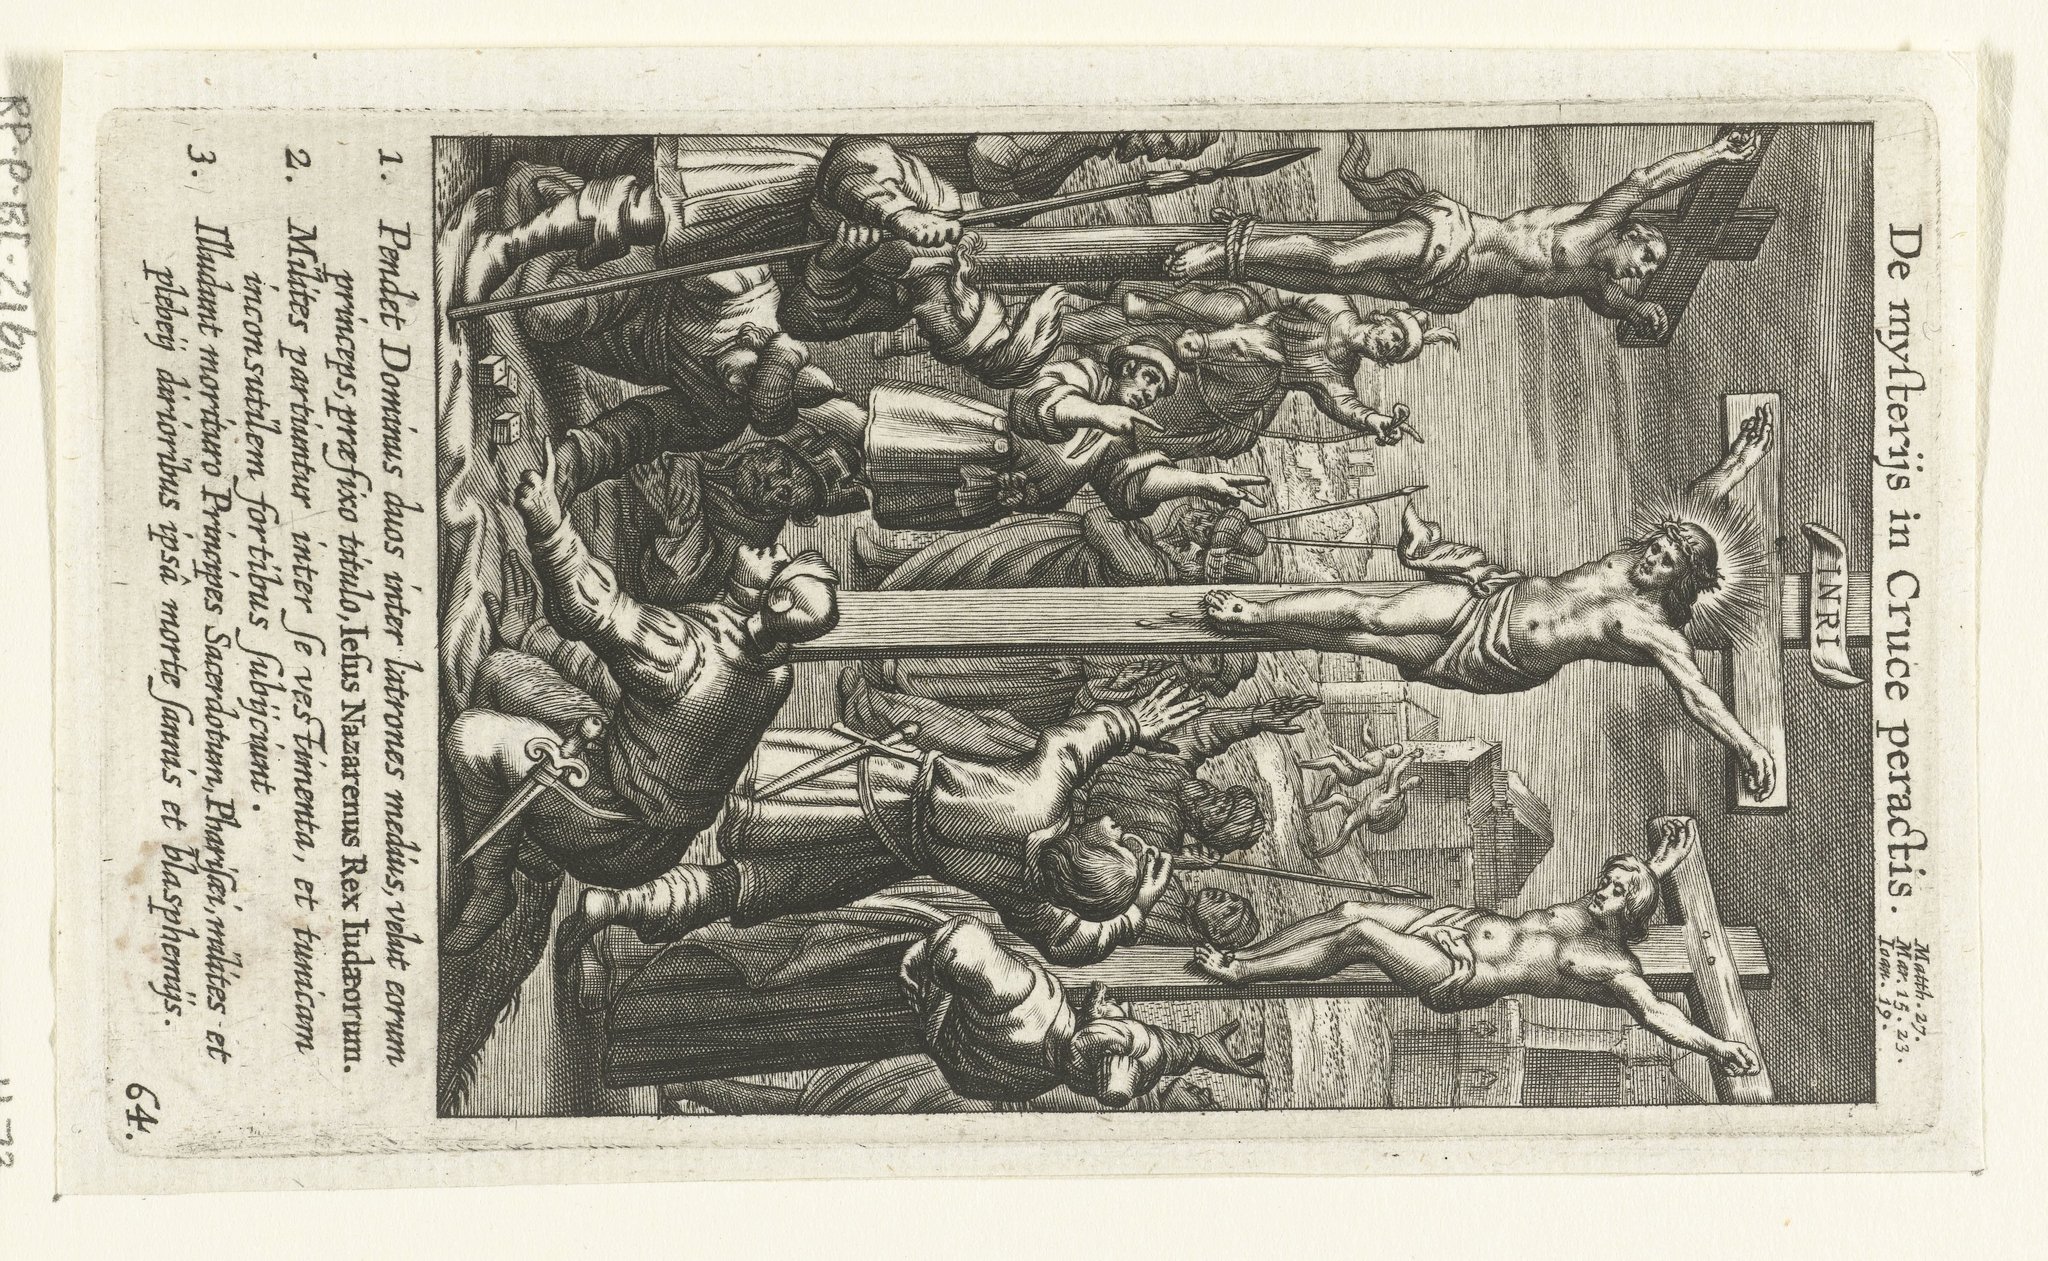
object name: book illustration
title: Christus aan het kruis en dobbelende soldaten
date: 1590-1622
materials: paper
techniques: engraving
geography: antwerp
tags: soldiers throwing dice for christ's seamless garment ~ christ's death on the cross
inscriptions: collector's mark: Lugt 240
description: Prent uit: Joannes Bourgois, Vitae passionis et mortis Jesu Christi Somini nostri mysteria, Antwerpen Hendrick Aertssens, 1622, afb. 64